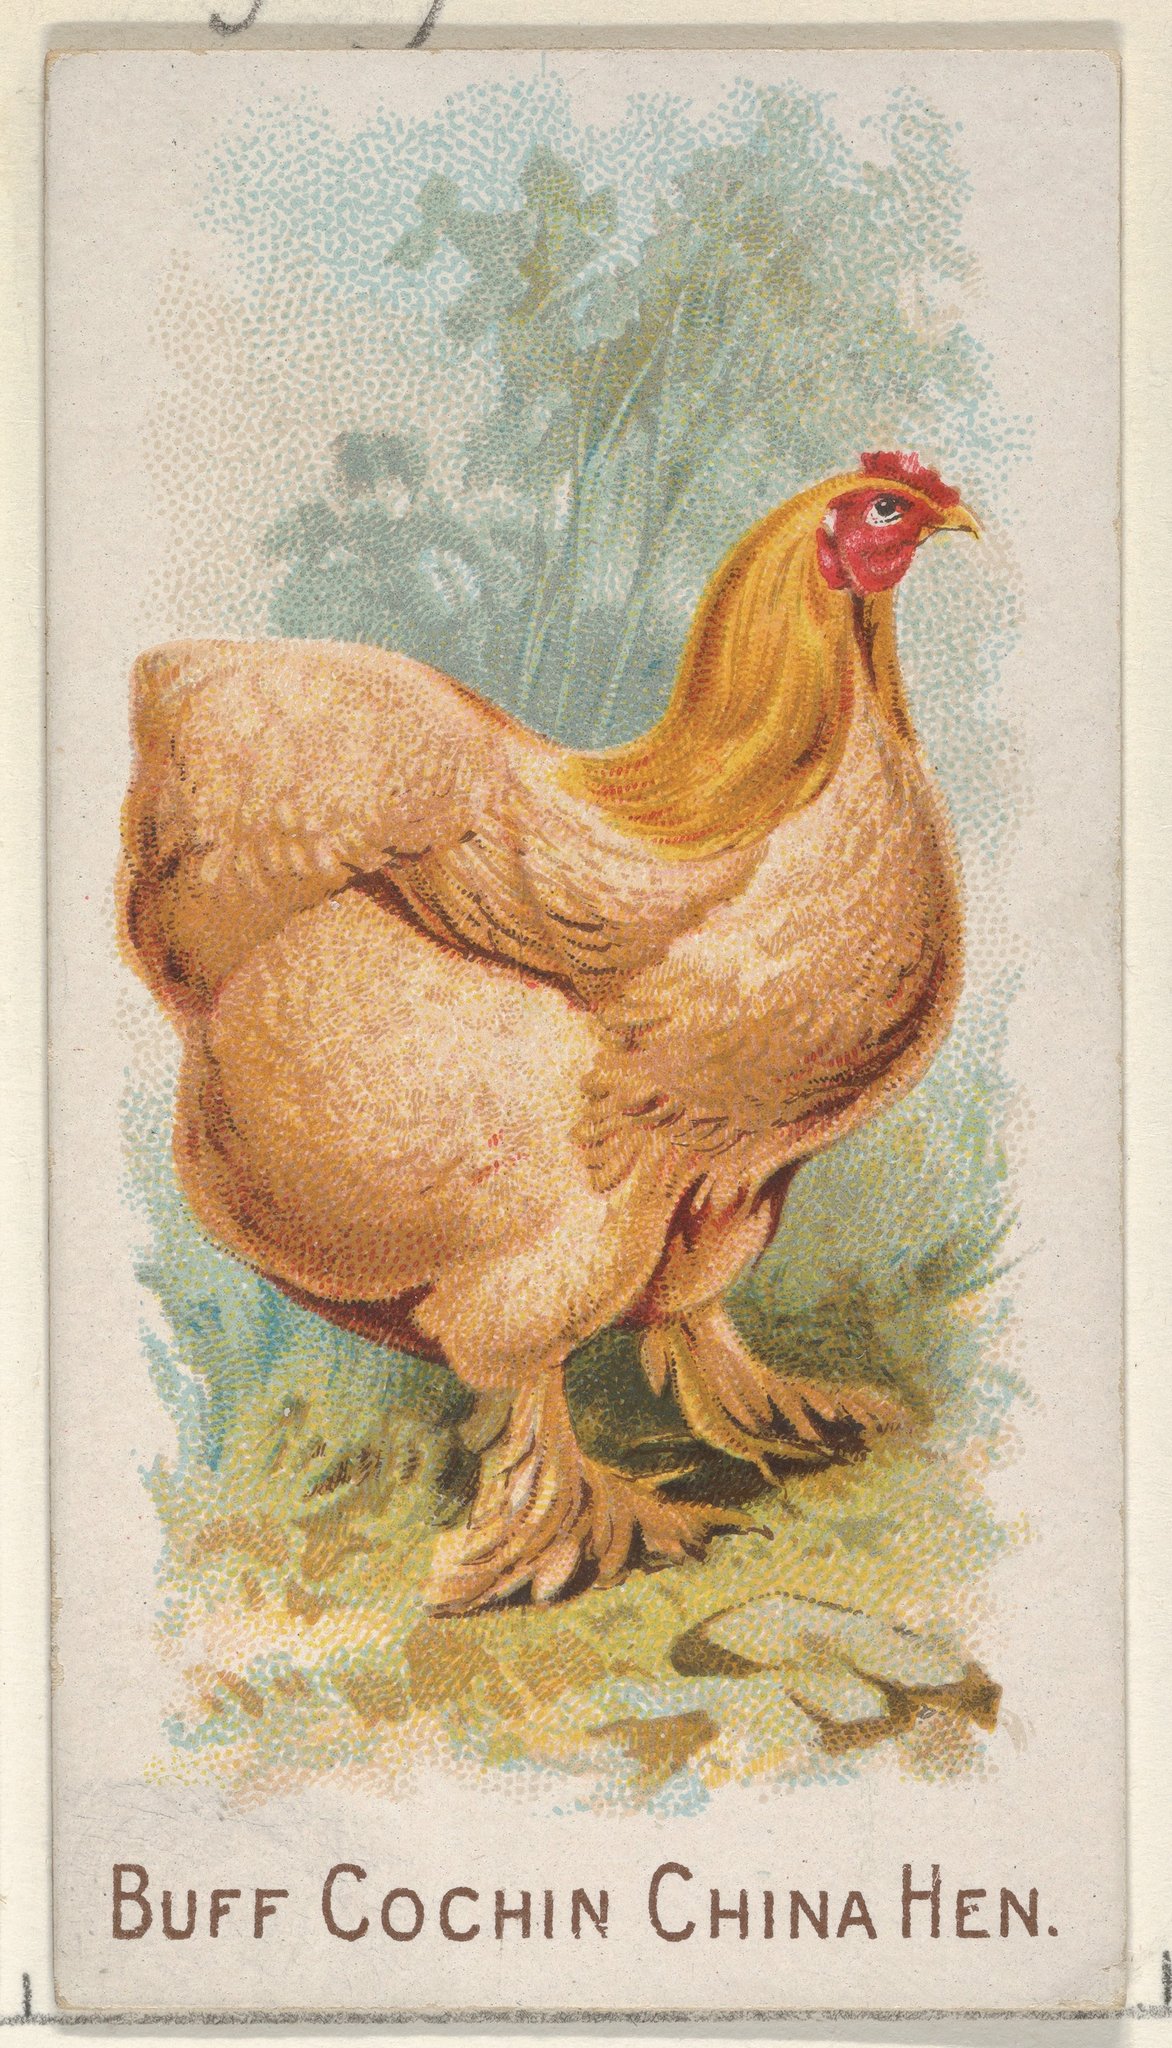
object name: print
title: Buff Cochin China Hen, from the Prize and Game Chickens series (N20) for Allen & Ginter Cigarettes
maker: allen & ginter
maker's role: publisher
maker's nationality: american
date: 1891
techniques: color lithograph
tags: chickens